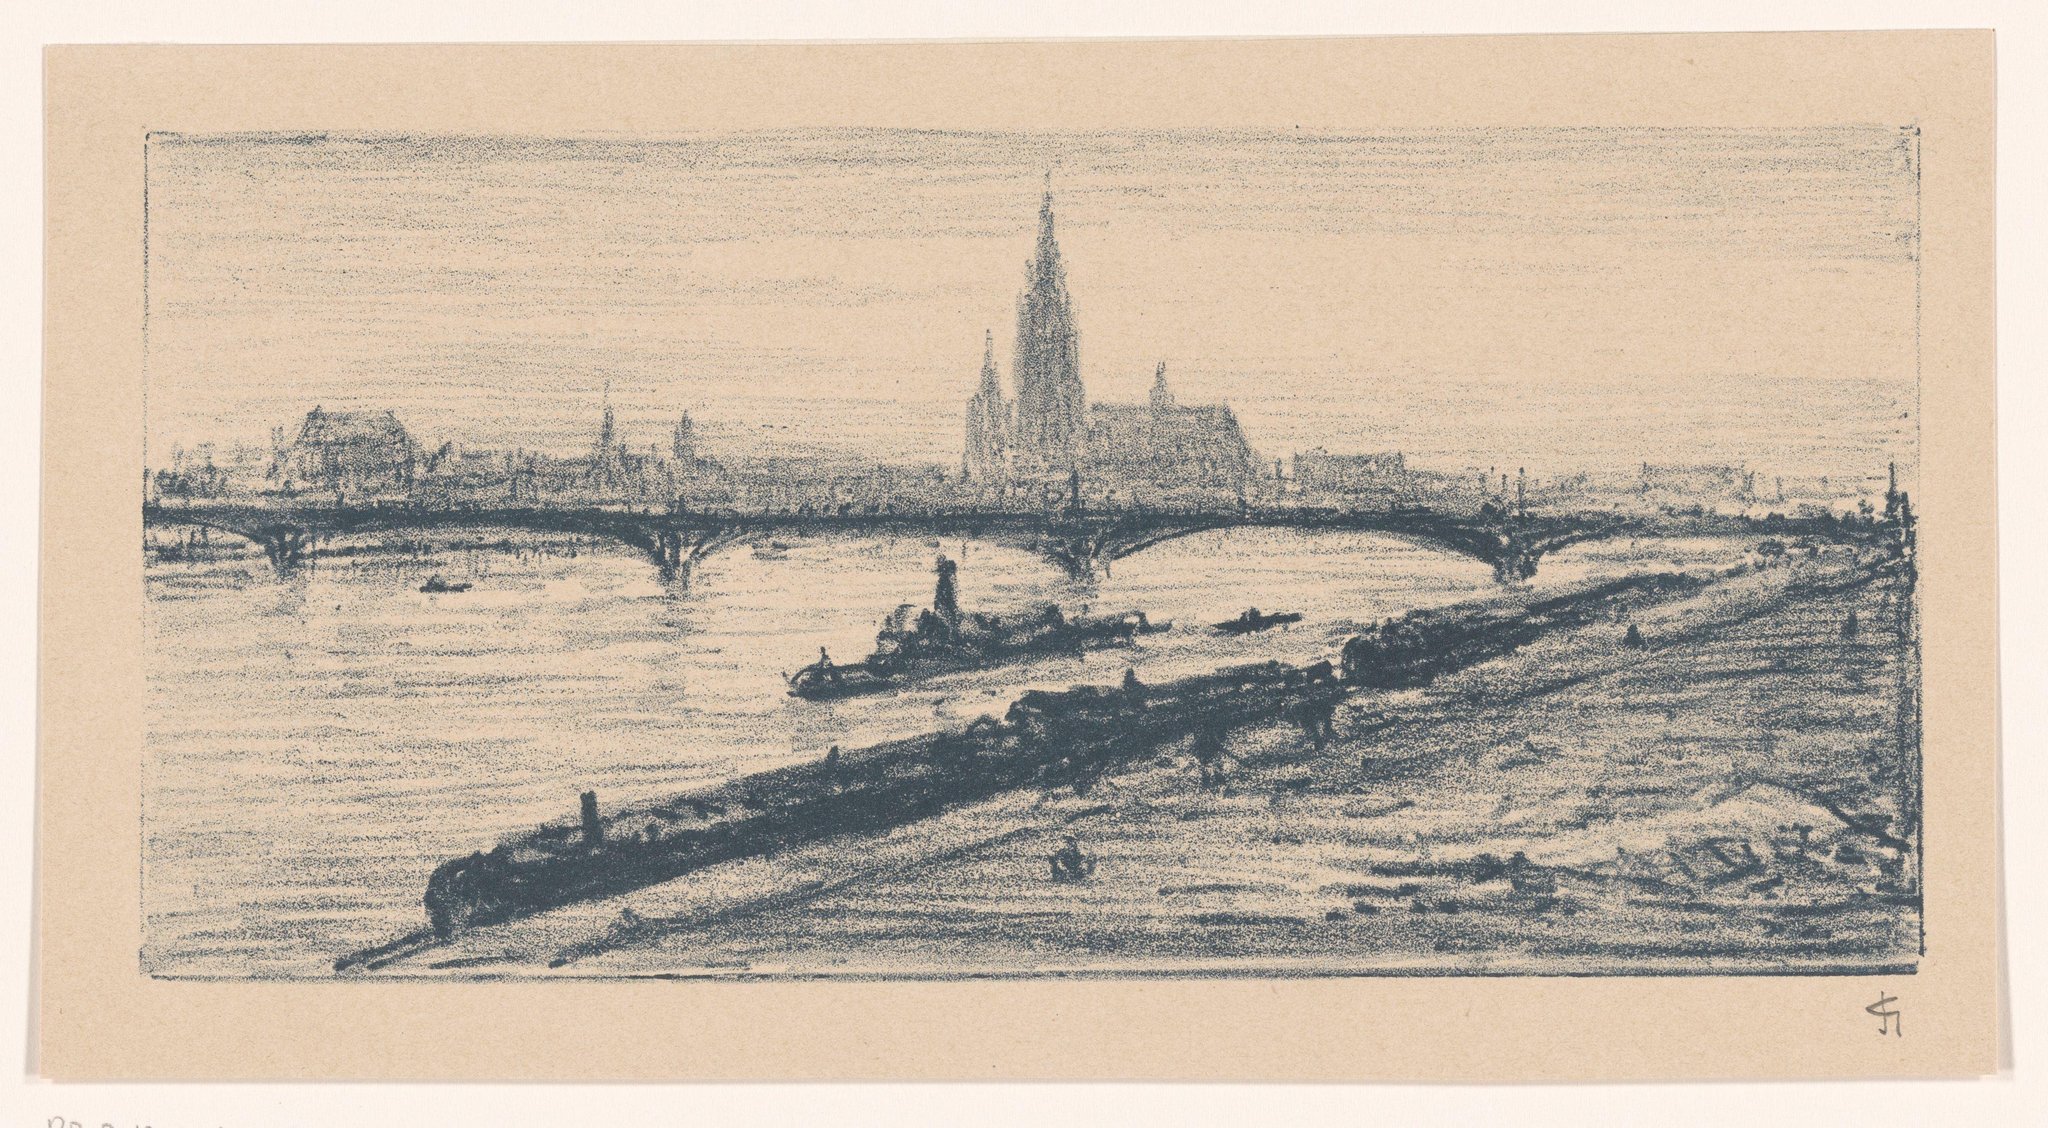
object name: print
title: Gezicht op Frankfurt am Main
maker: carel nicolaas storm van s-gravesande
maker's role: draughtsman, print maker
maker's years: 1841-1924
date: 1851-1902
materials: paper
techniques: lithograph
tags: church (exterior), bridge in city across river, canal, etc.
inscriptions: collector's mark: Lugt 2228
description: Mogelijk vermeld in: Storm van 's-Gravesande, Charles. Catalogue des eaux-fortes et lithographies. New York: s.n., 1903, of in een onbekende latere uitgave van het manuscript. Vermoedelijk vermeld als catalogusnummer 60.